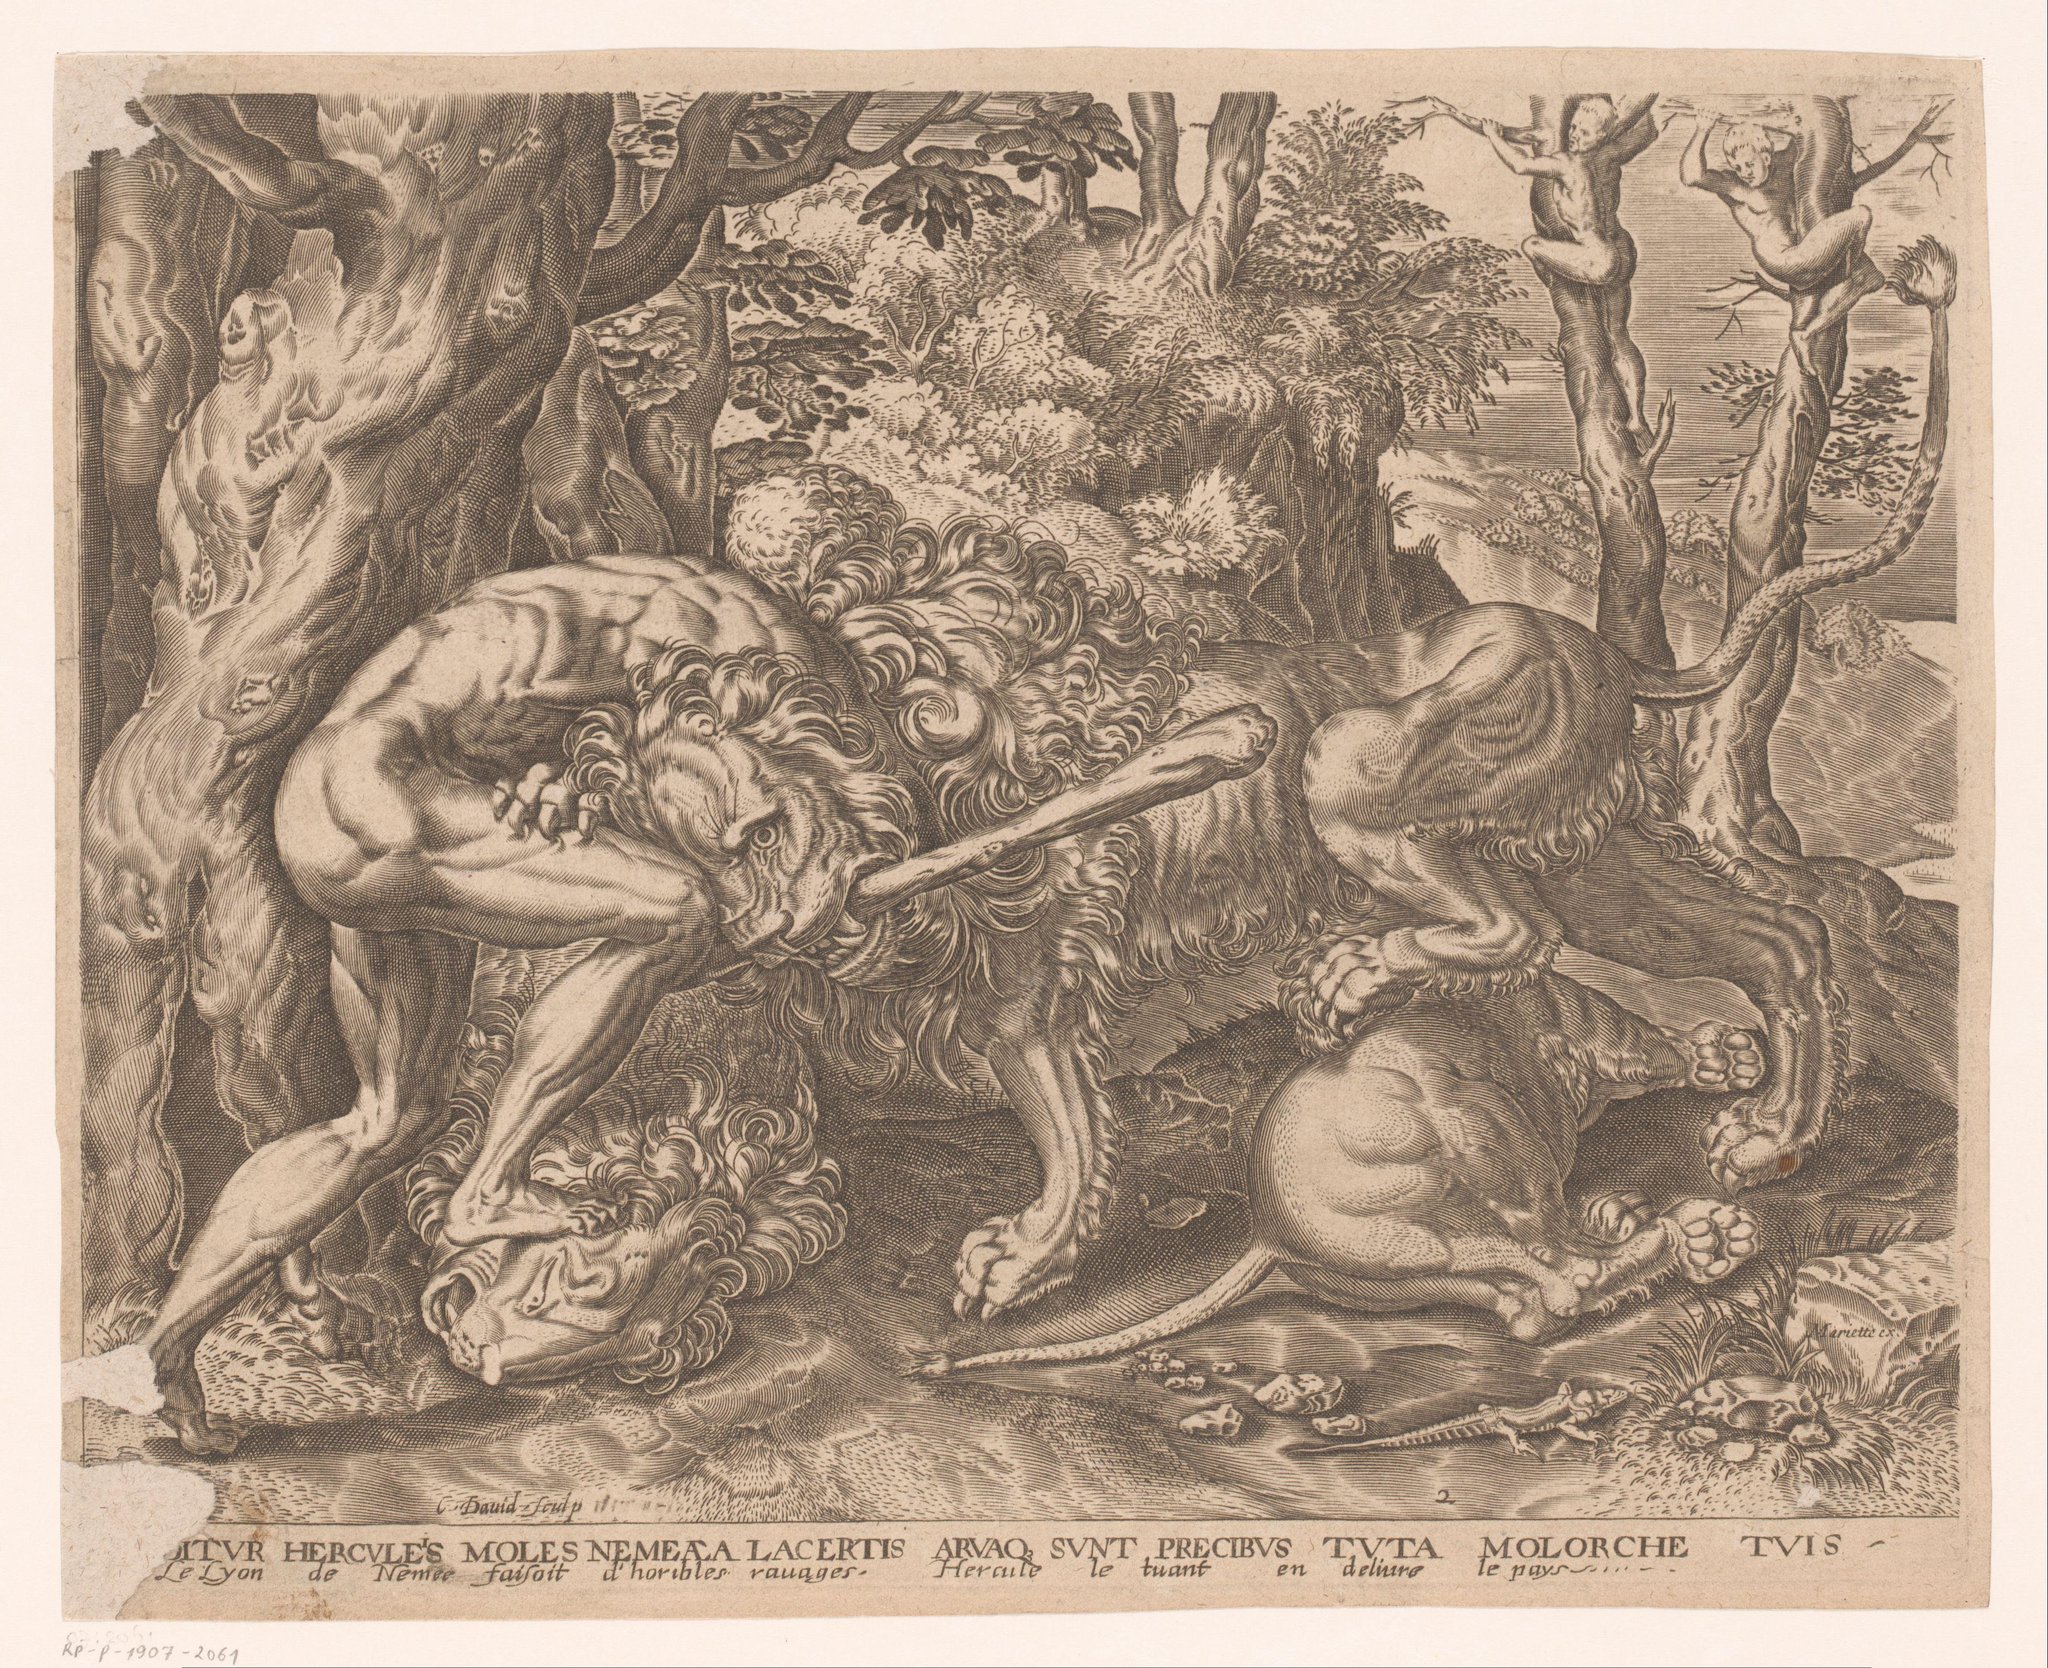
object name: print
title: Werken van Hercules naar Frans Floris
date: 1613-1638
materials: paper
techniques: engraving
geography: paris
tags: (1) hercules chokes the nemean lion with his arms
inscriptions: collector's mark: Lugt 2228